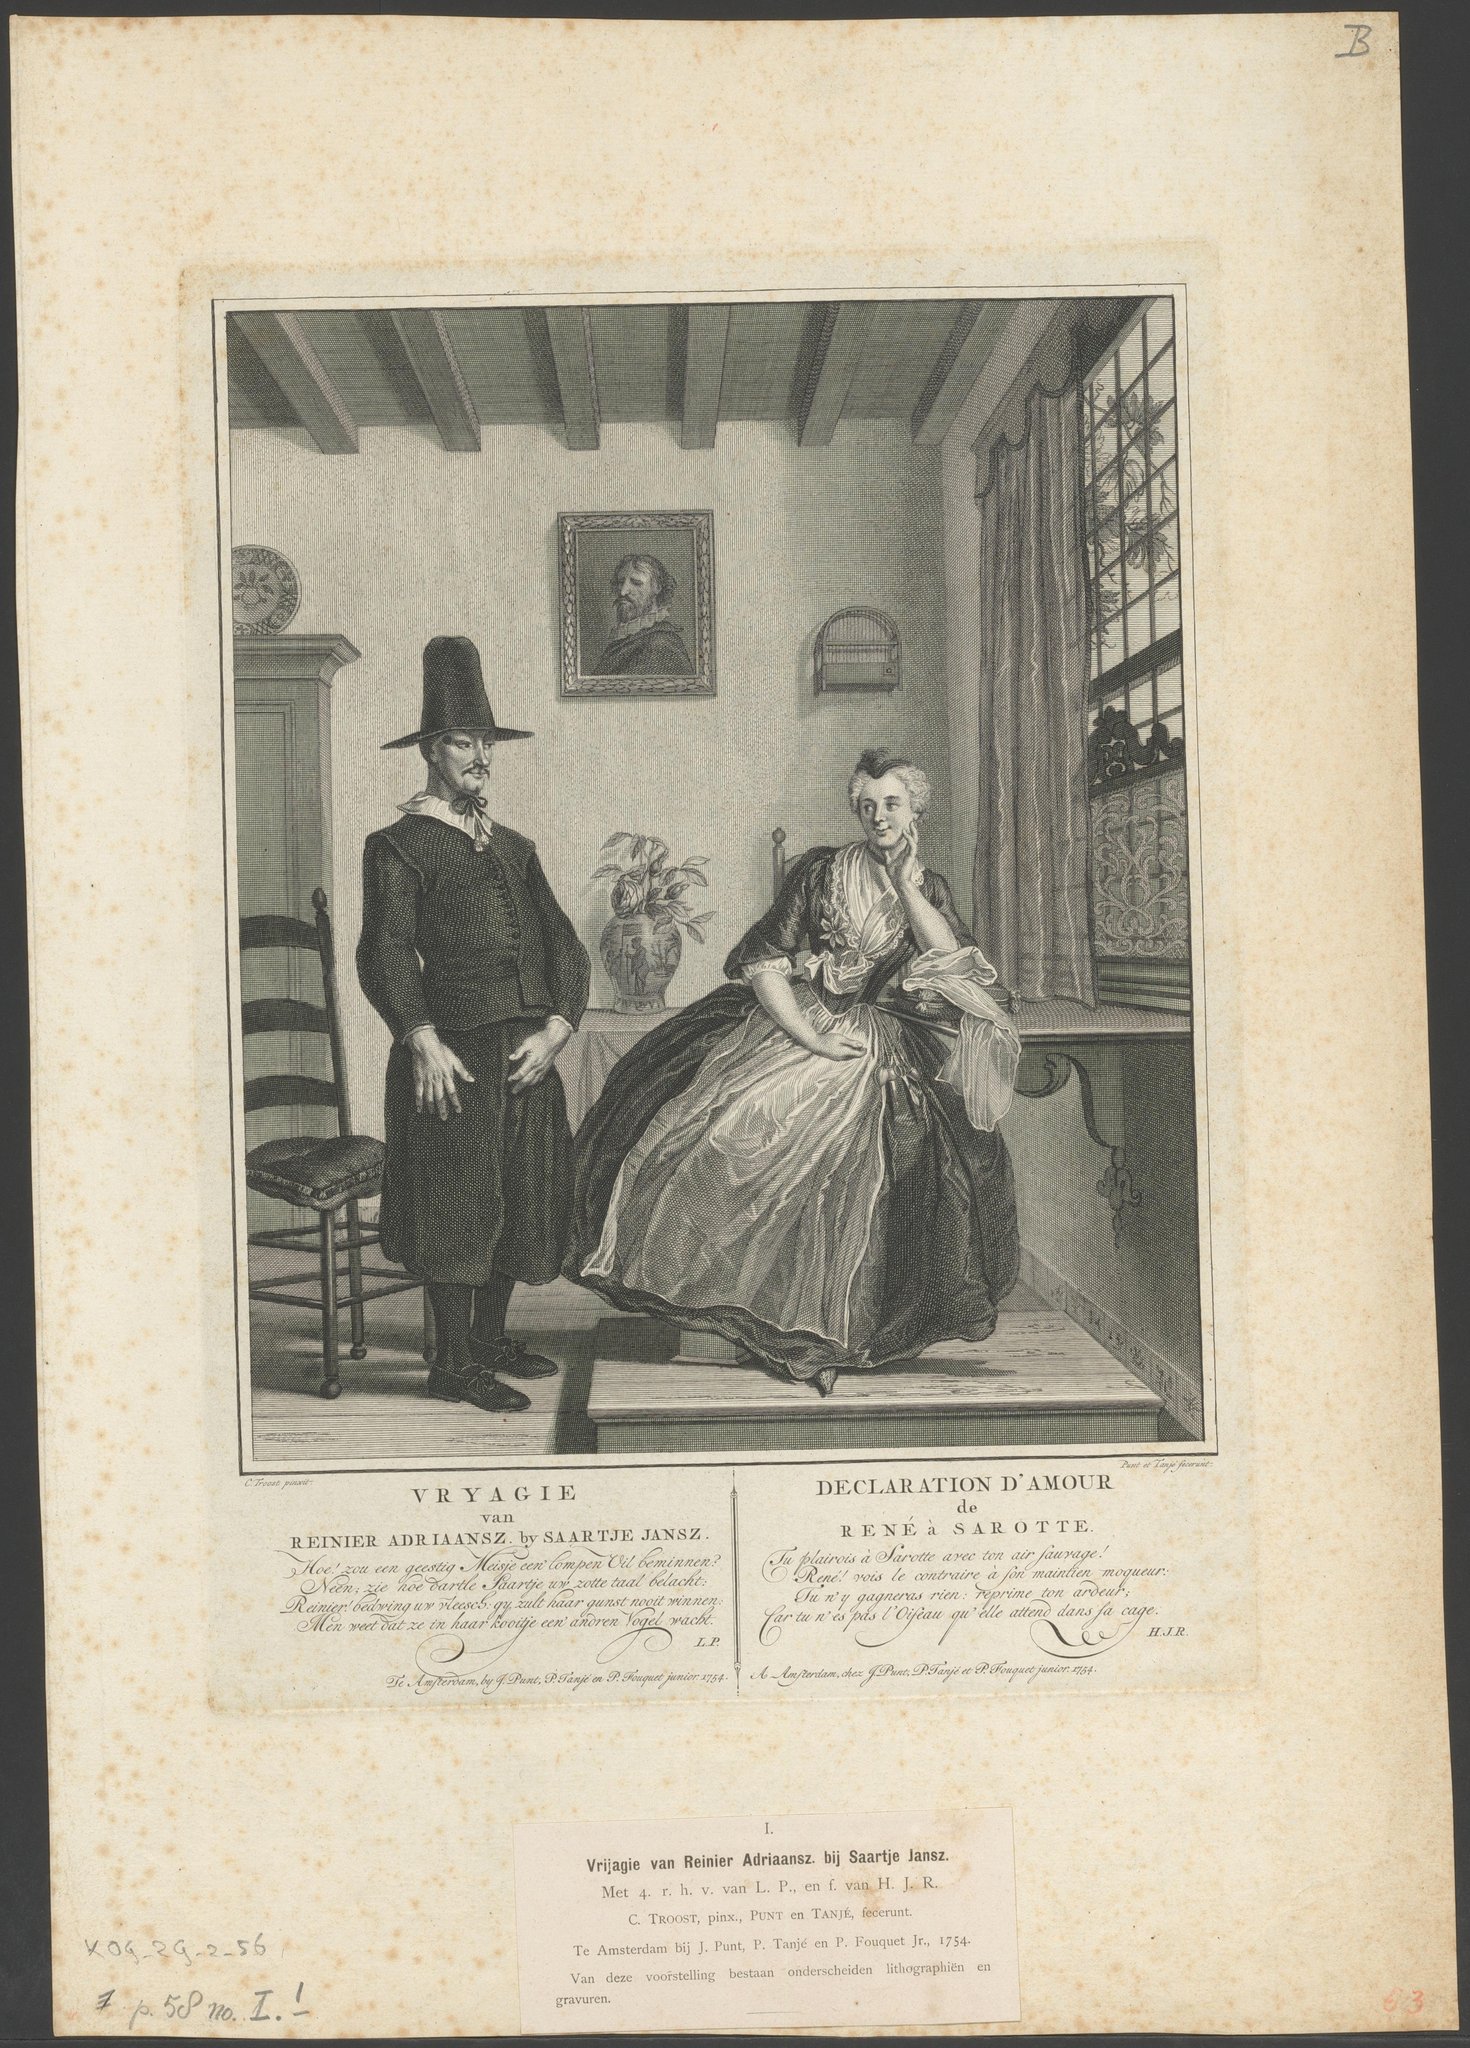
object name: print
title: Jan Claasz of de gewaande dienstmaagd: de liefdesverklaring van Reinier Adriaansz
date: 1754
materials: paper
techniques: engraving, etching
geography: amsterdam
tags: being refused, the proposal rejected, living-room, parlour, sitting-room, comedy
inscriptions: collector's mark: Lugt 2488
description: Reinier Adriaansz verklaart Saartje Jansz. in een huiskamer zijn liefde. Saartje Jansz wijst hem echter af. Onderaan in de marge een vierregelig vers in het Nederlands en het Frans. Scène uit de komedie 'Jan Claasz of de gewaande dienstmaagd' van Thomas Asselijn.